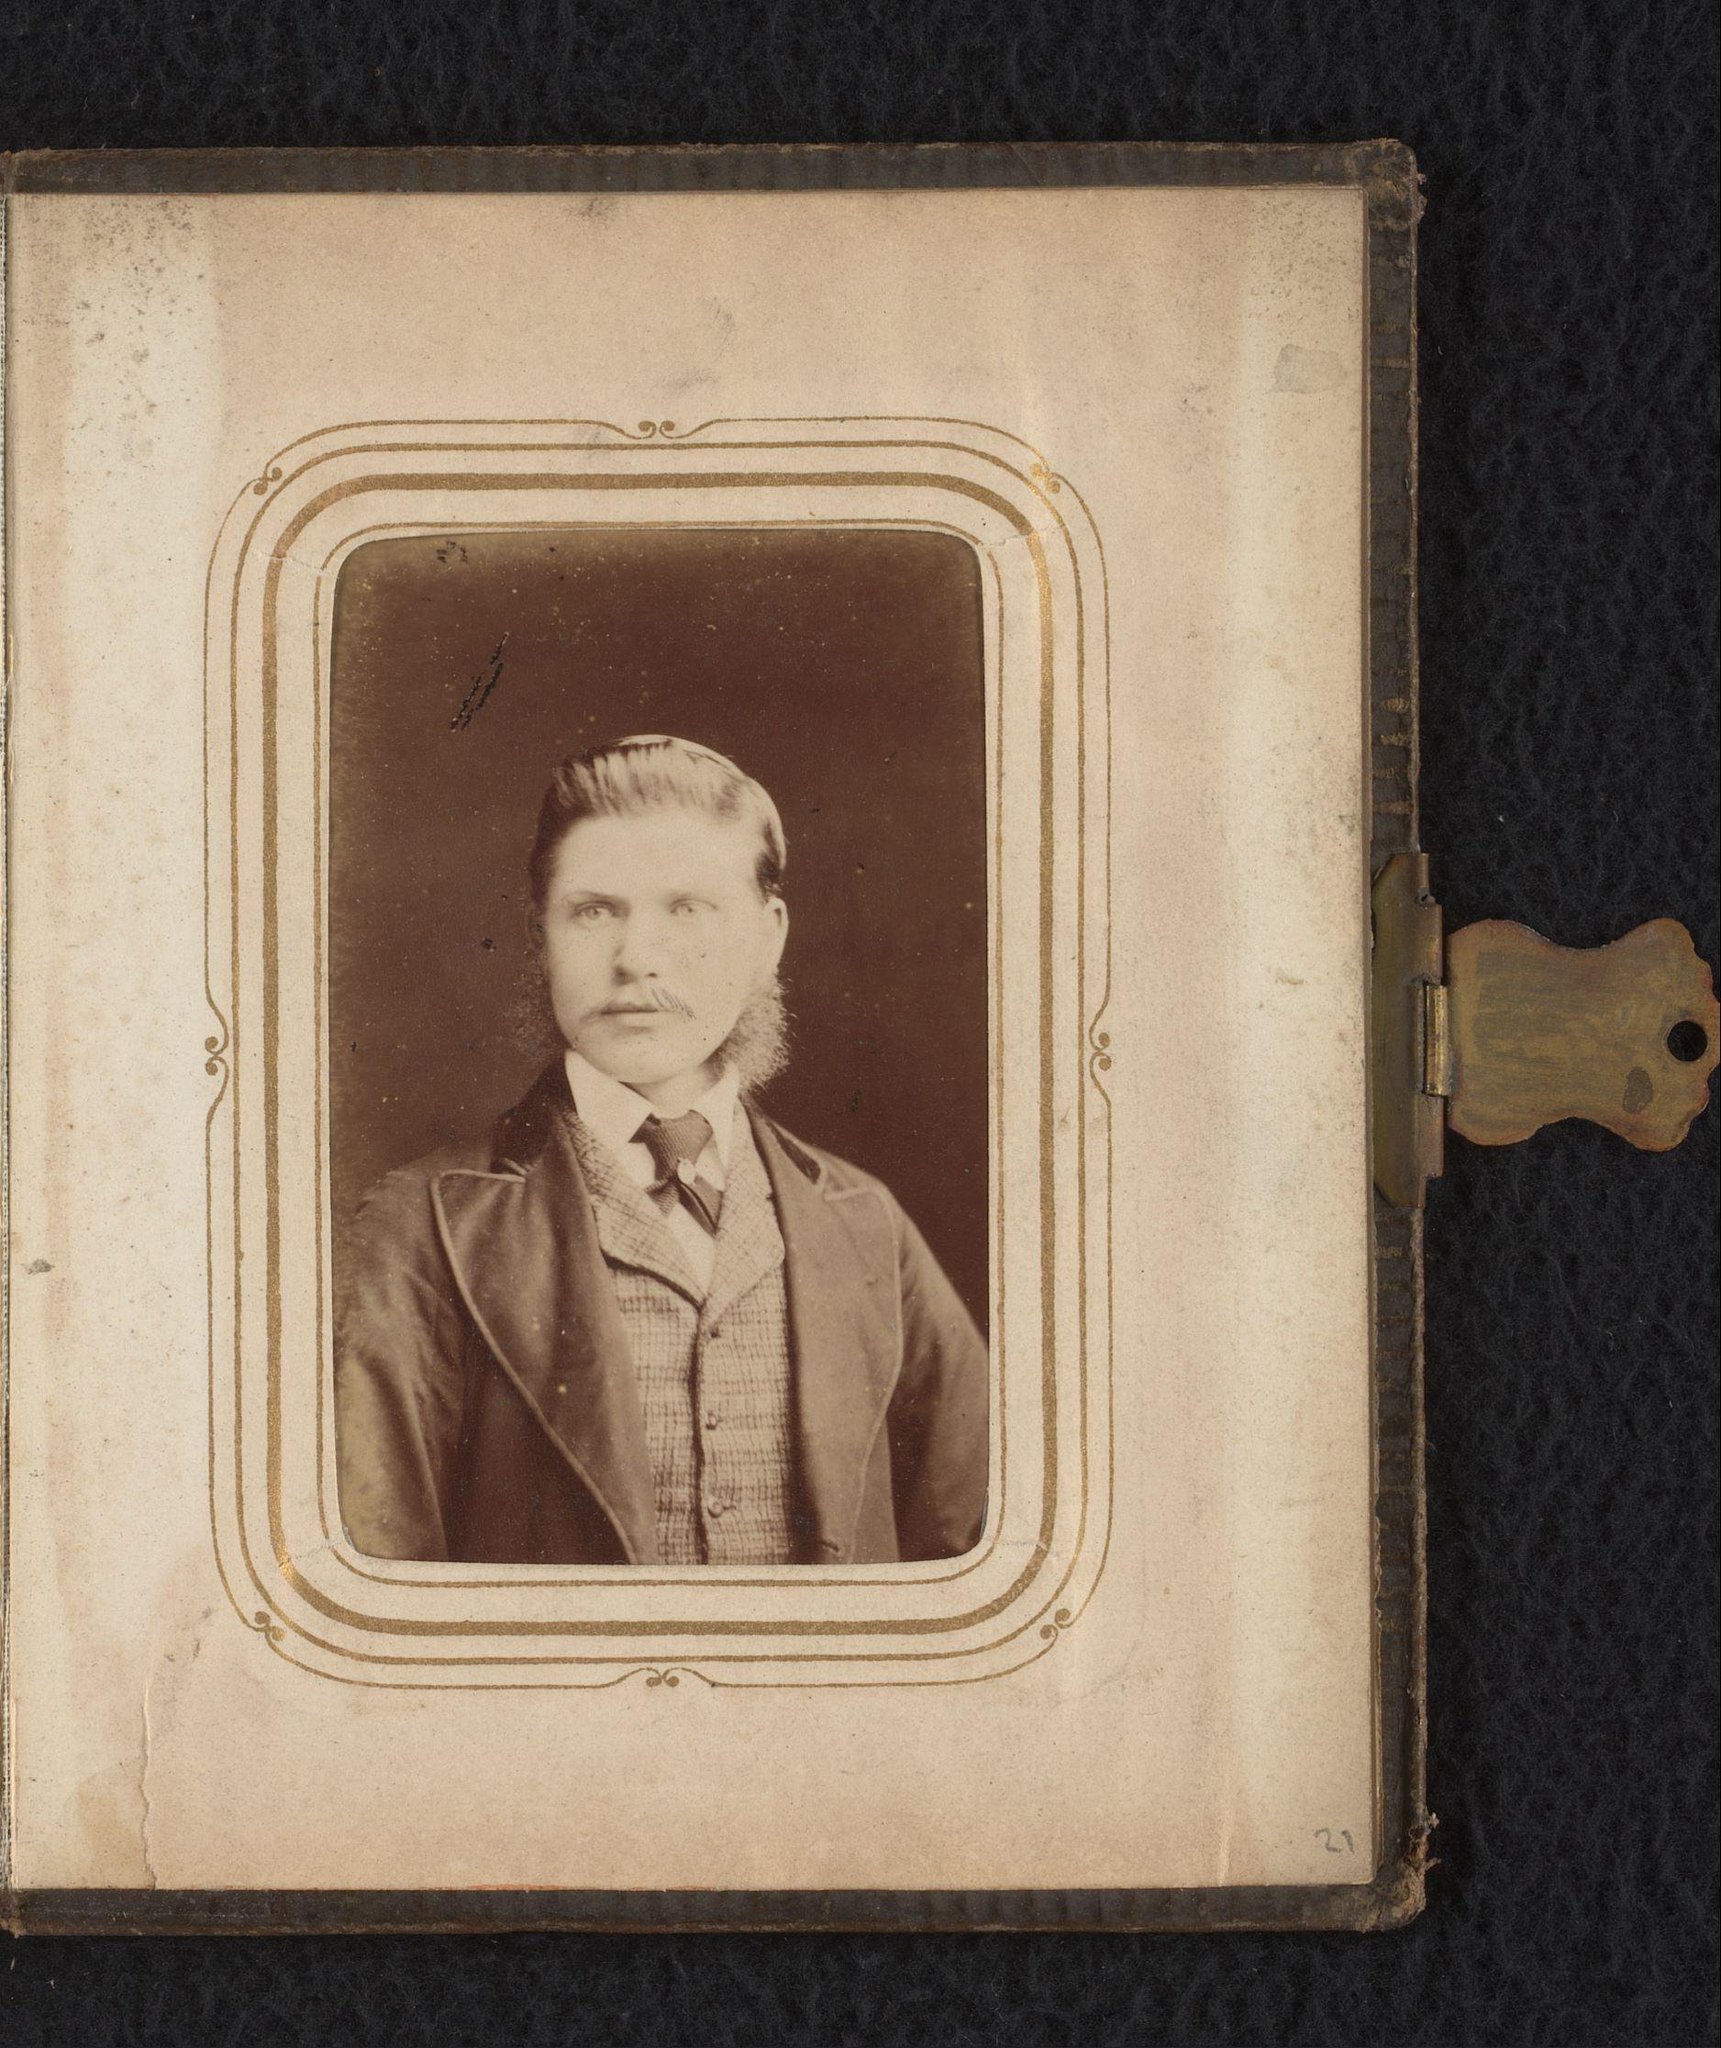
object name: photograph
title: Portret van een jongeman met bakkebaarden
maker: frederick argall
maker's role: fotograaf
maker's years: 1847-1900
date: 1860-1900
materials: cardboard, photographic support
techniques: albumen print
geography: truro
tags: sideburns, youth, adolescent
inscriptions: inscription: ‘Frederick Argall/ High Coss/ Truro’